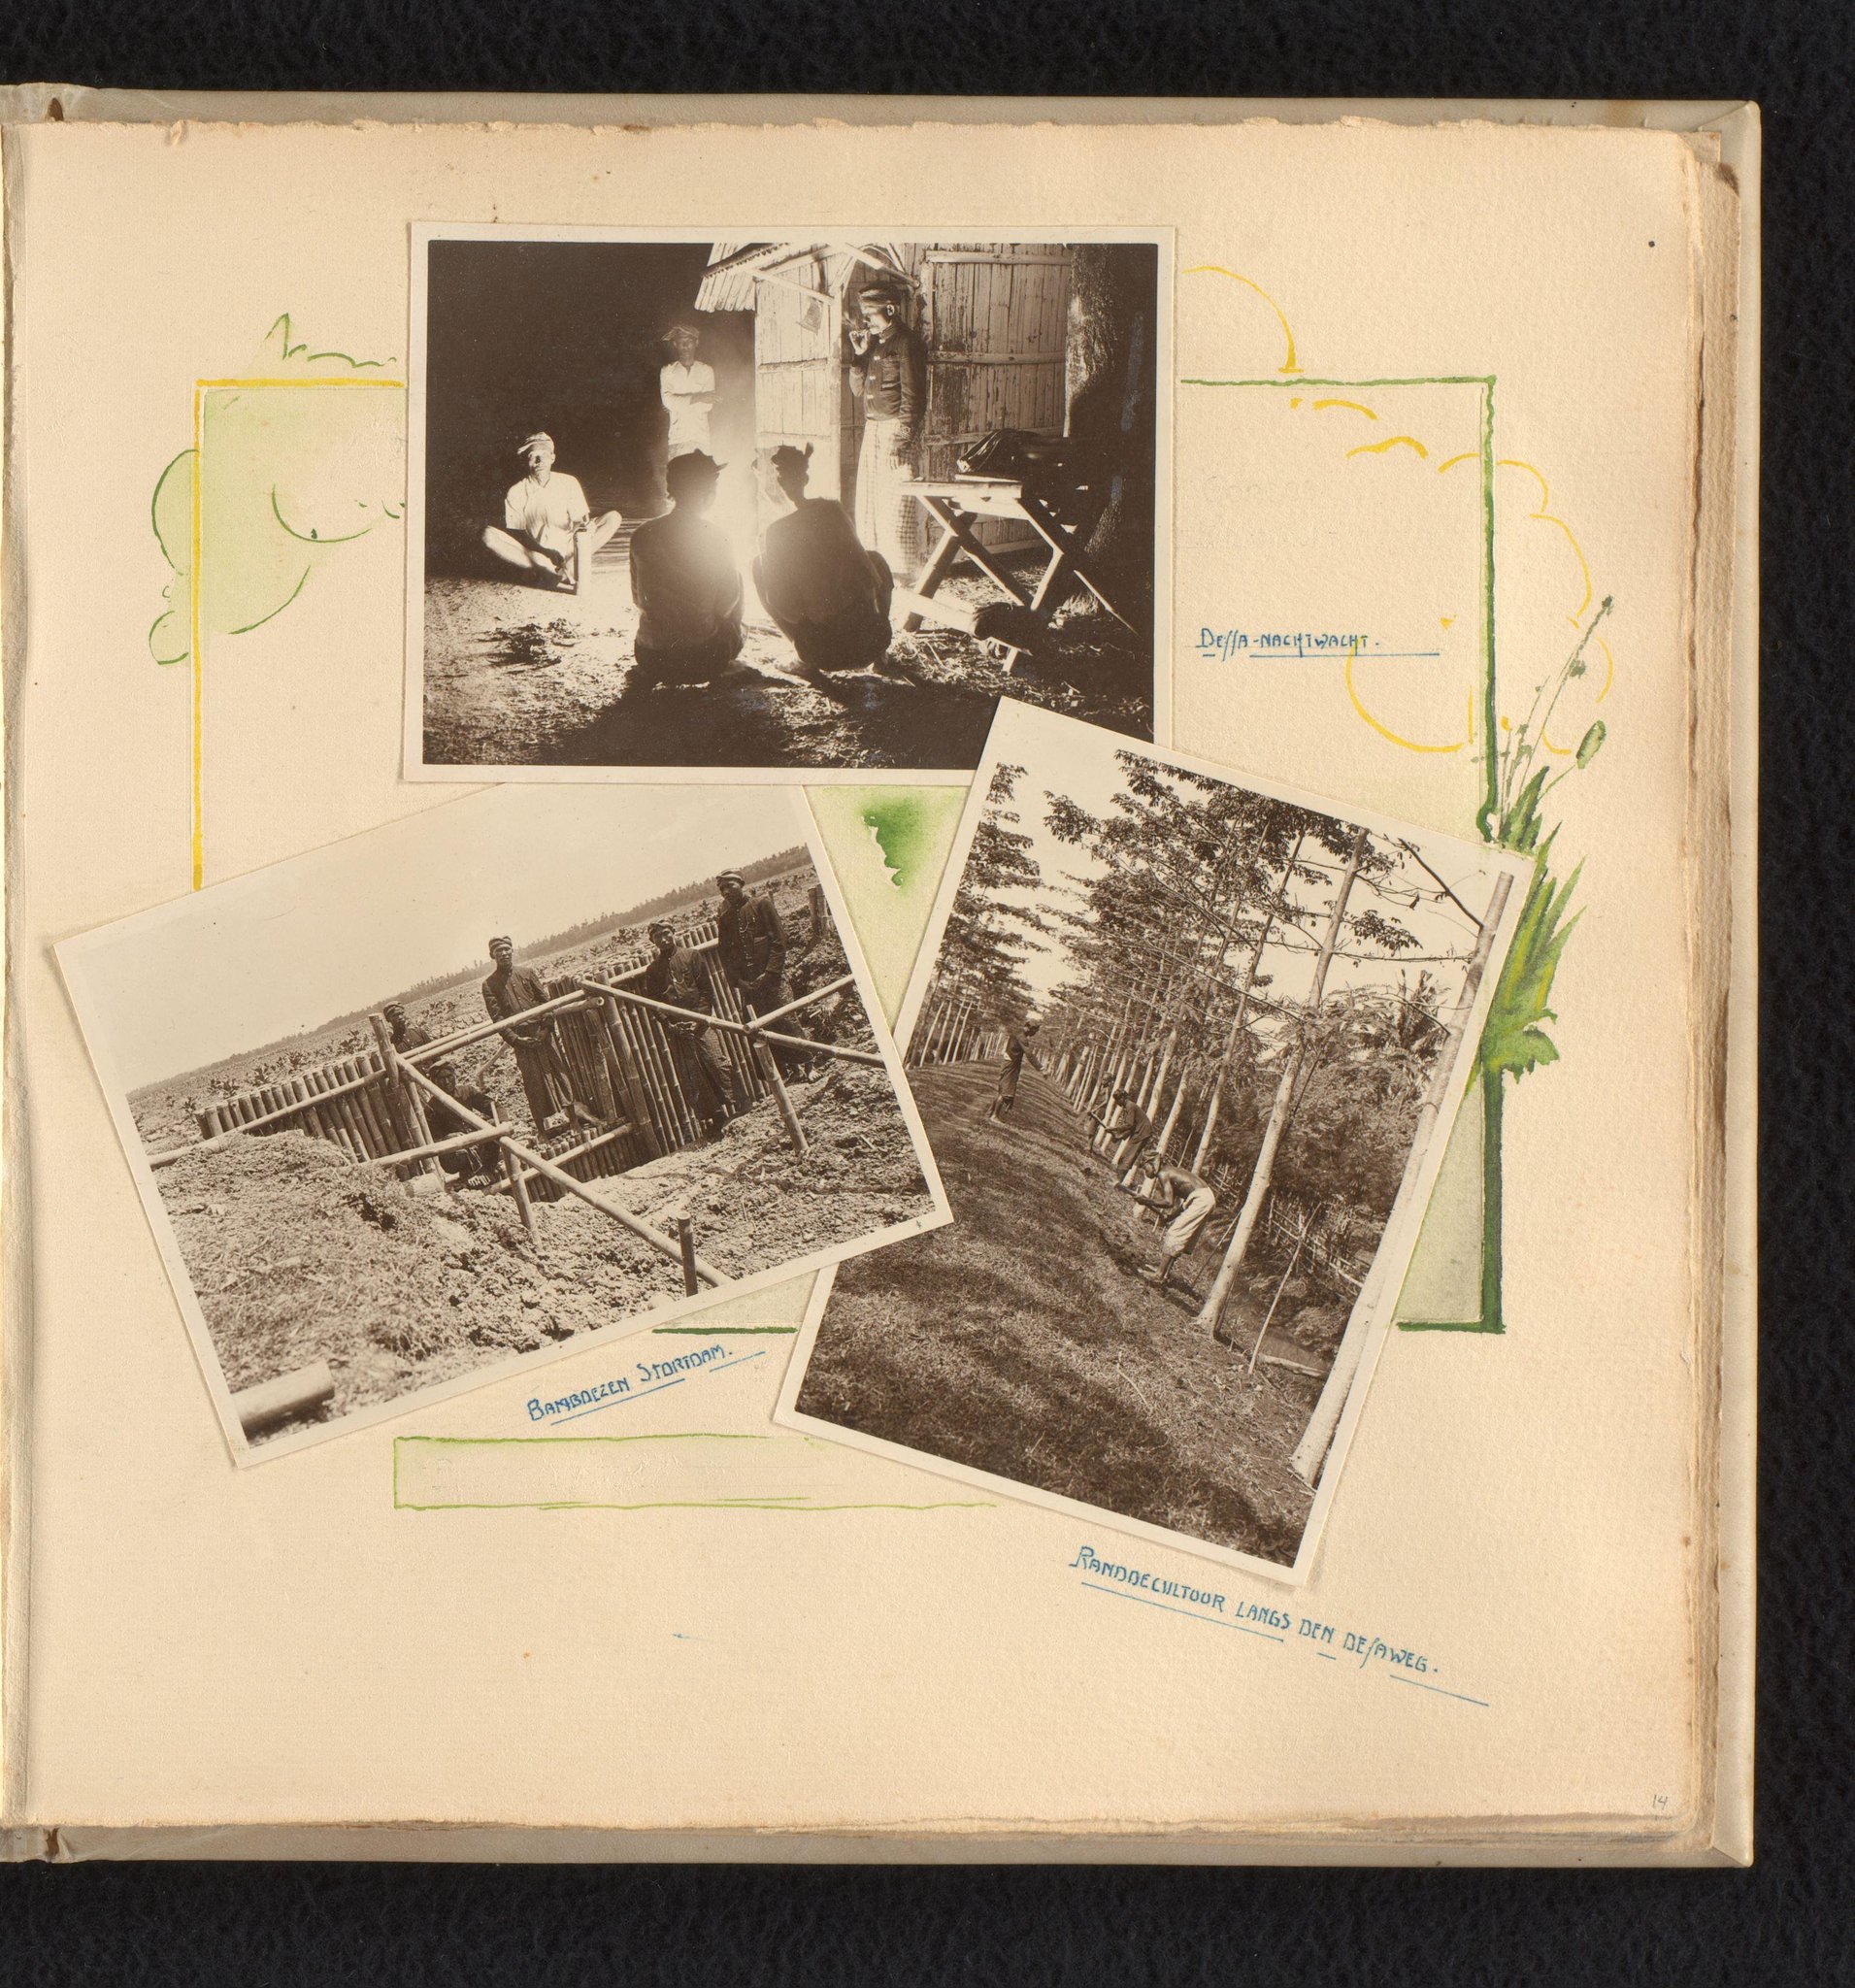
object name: photograph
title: Verschillende werkzaamheden te Grobogan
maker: Anonymous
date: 1910-1928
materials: paper, photographic support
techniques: drawing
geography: grobogan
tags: agriculture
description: Albumblad met drie foto's van verschillende soorten werkzaamheden in Grobogan. Het blad is versierd met randwerk om de foto's. Onderdeel van het fotoalbum aangeboden aan J. Habbema door het Binnenlandsch Bestuur Corps van het Regentschap Grobogan, bij het beëindigen van zijn bestuur over het Regentschap, waarschijnlijk in 1928.